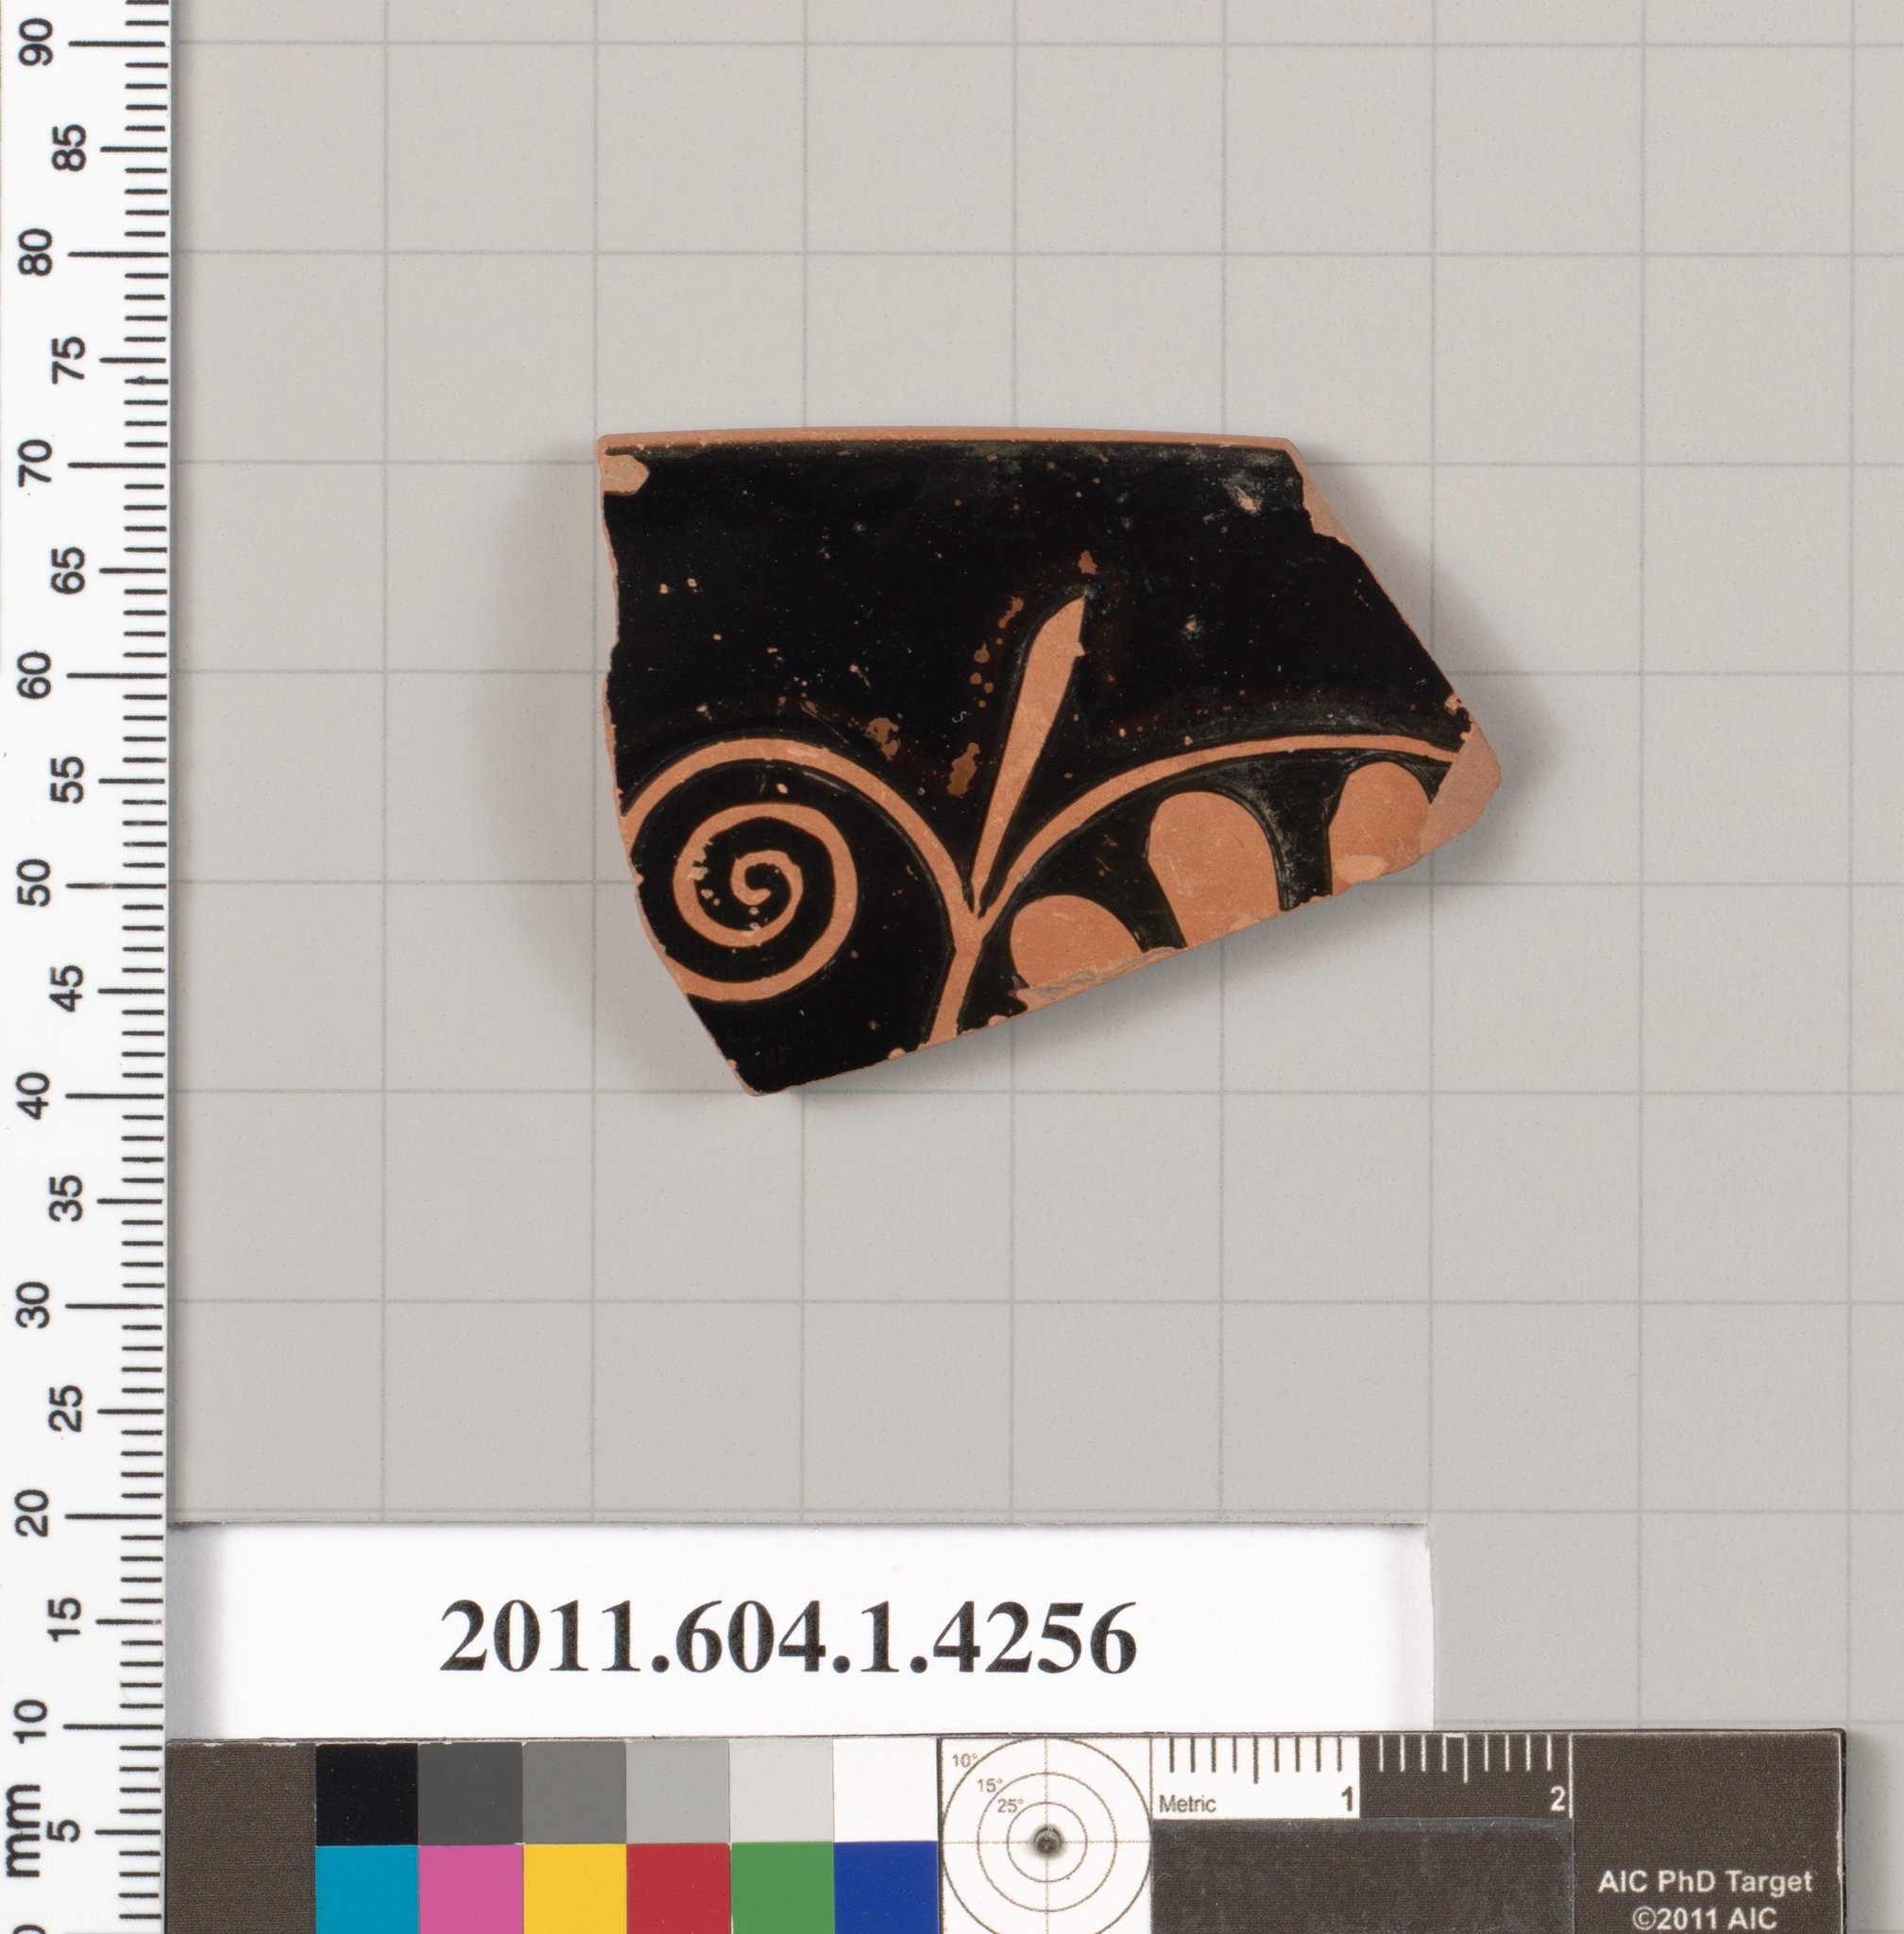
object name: kylix fragment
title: Terracotta rim fragment of a kylix (drinking cup)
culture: greek, attic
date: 520-500 BCE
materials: terracotta